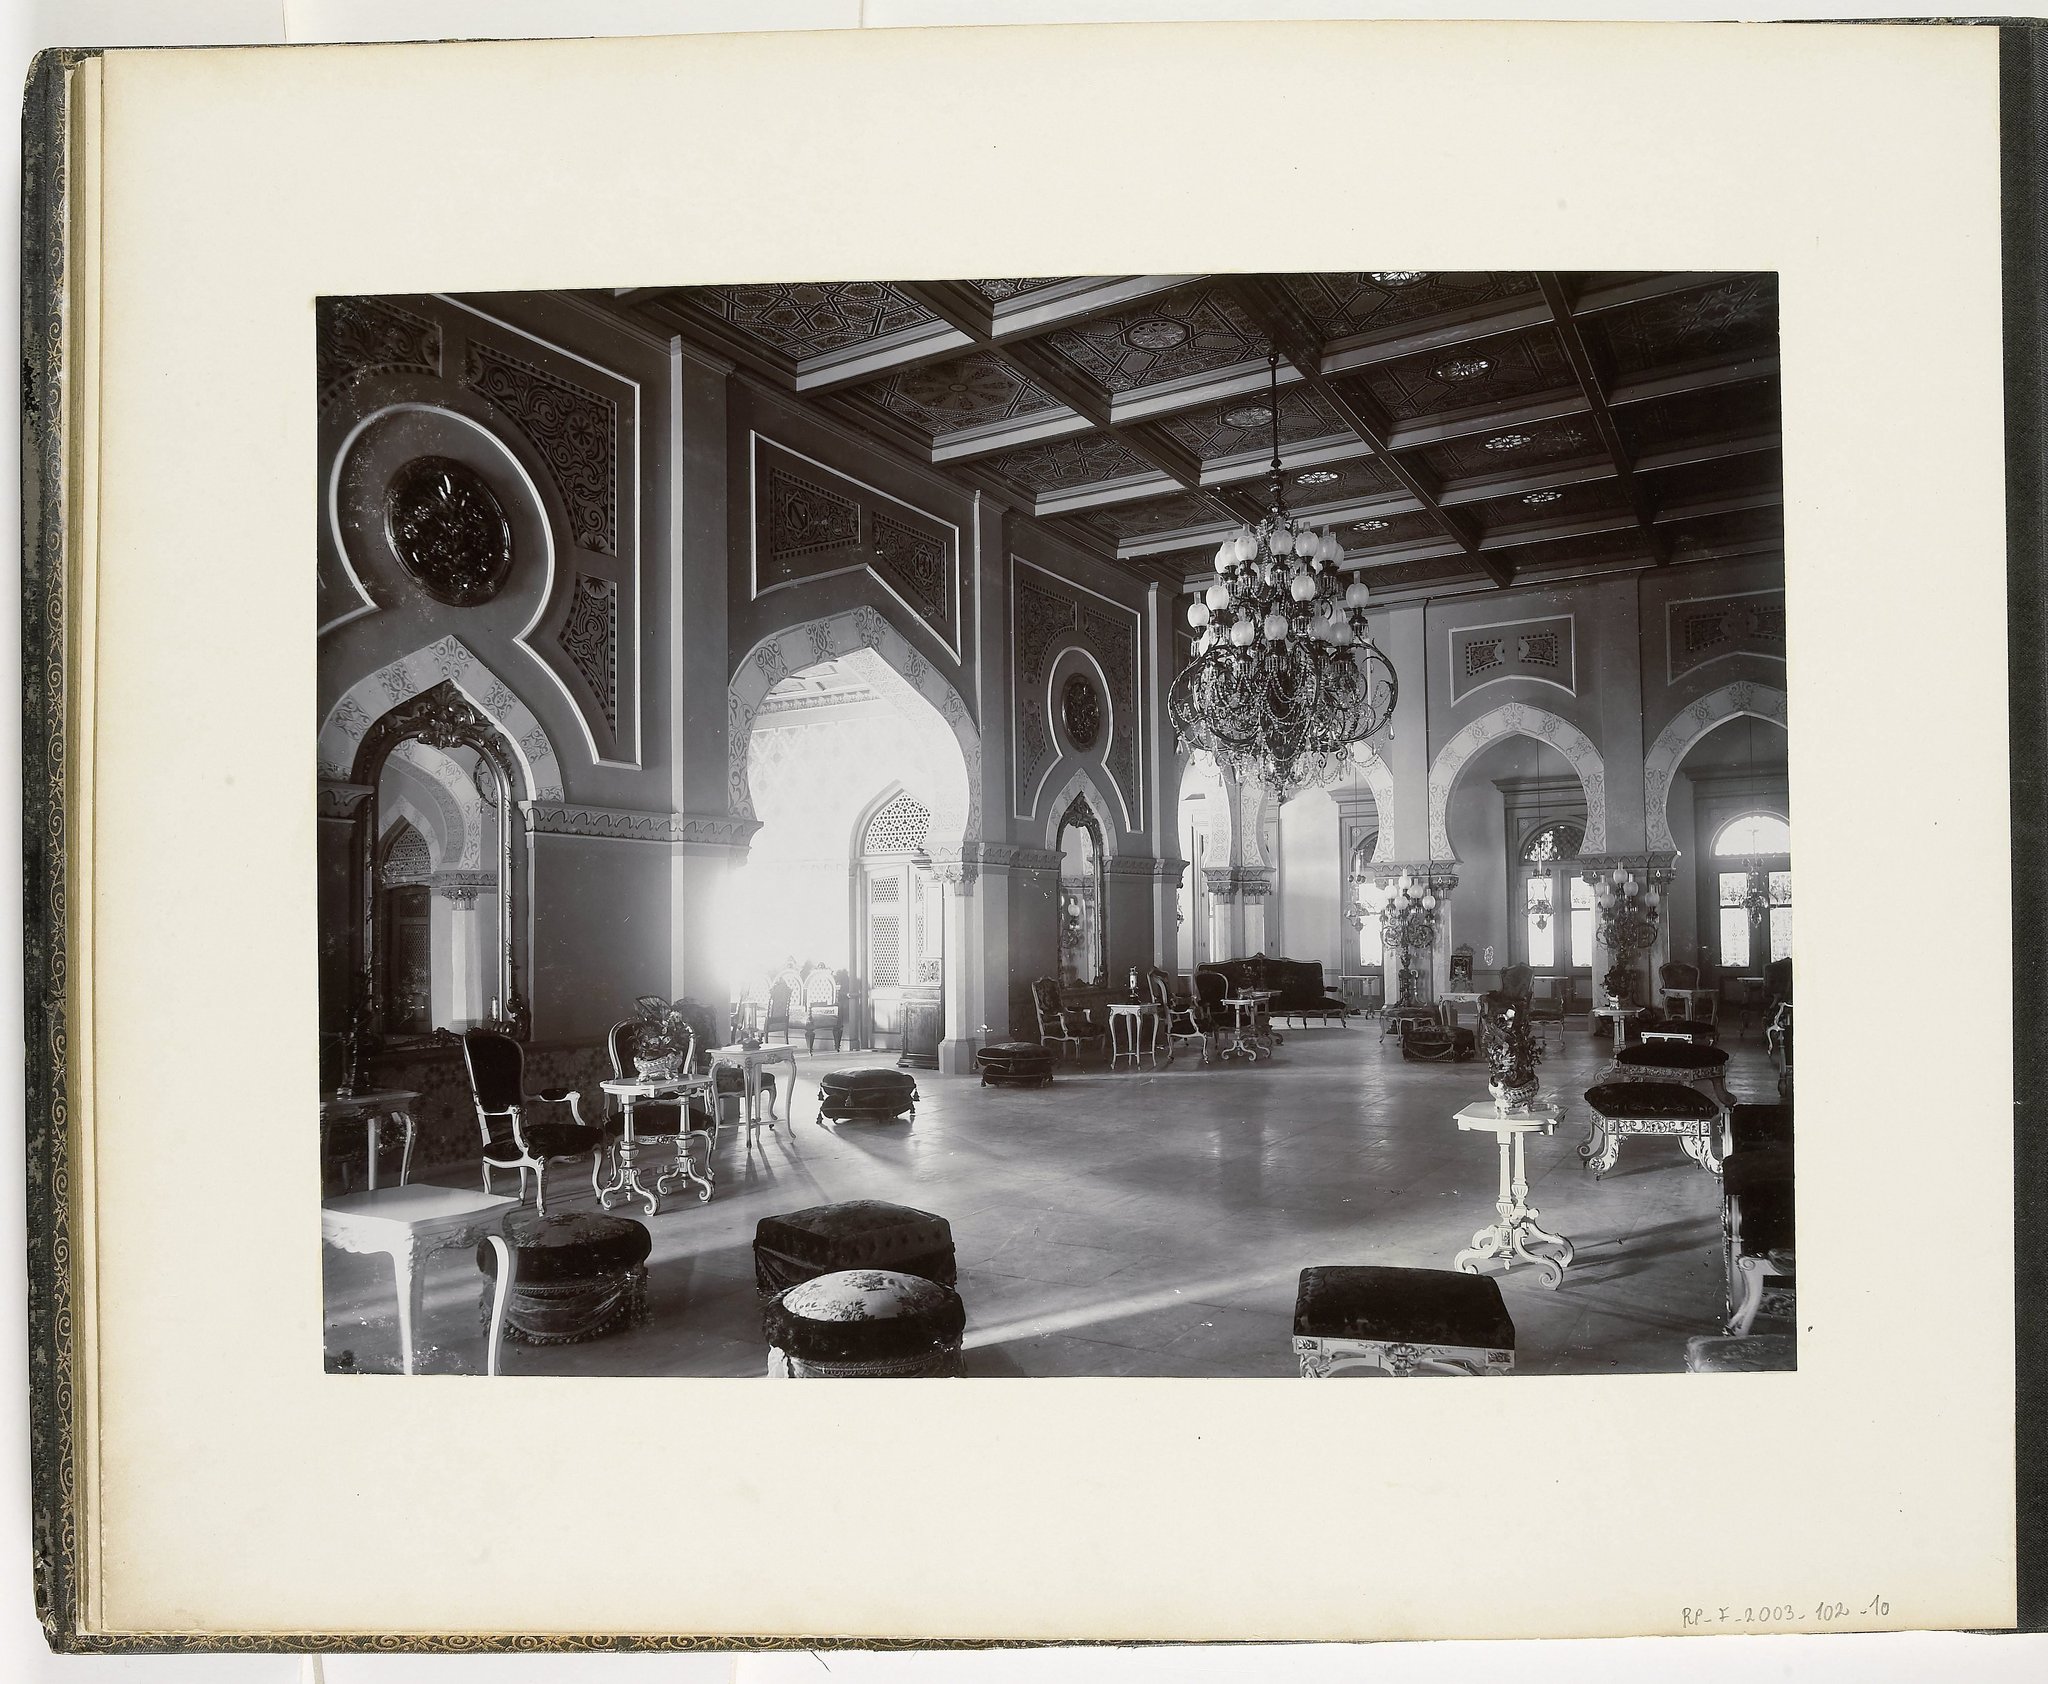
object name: photograph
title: Interieur van het paleis van de Sultan van Deli, Sumatra (Palais des Sultans von Deli Interieur)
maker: carl j. kleingrothe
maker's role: fotograaf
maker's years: 1864-1925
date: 1885-1900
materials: photographic support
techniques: collodion silver print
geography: medan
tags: medan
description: Gezicht in het interieur van het paleis van de sultan van Deli in Medan. Onderdeel van het Sumatra fotoalbum van Paul en Lucie Sandel uit 1900.